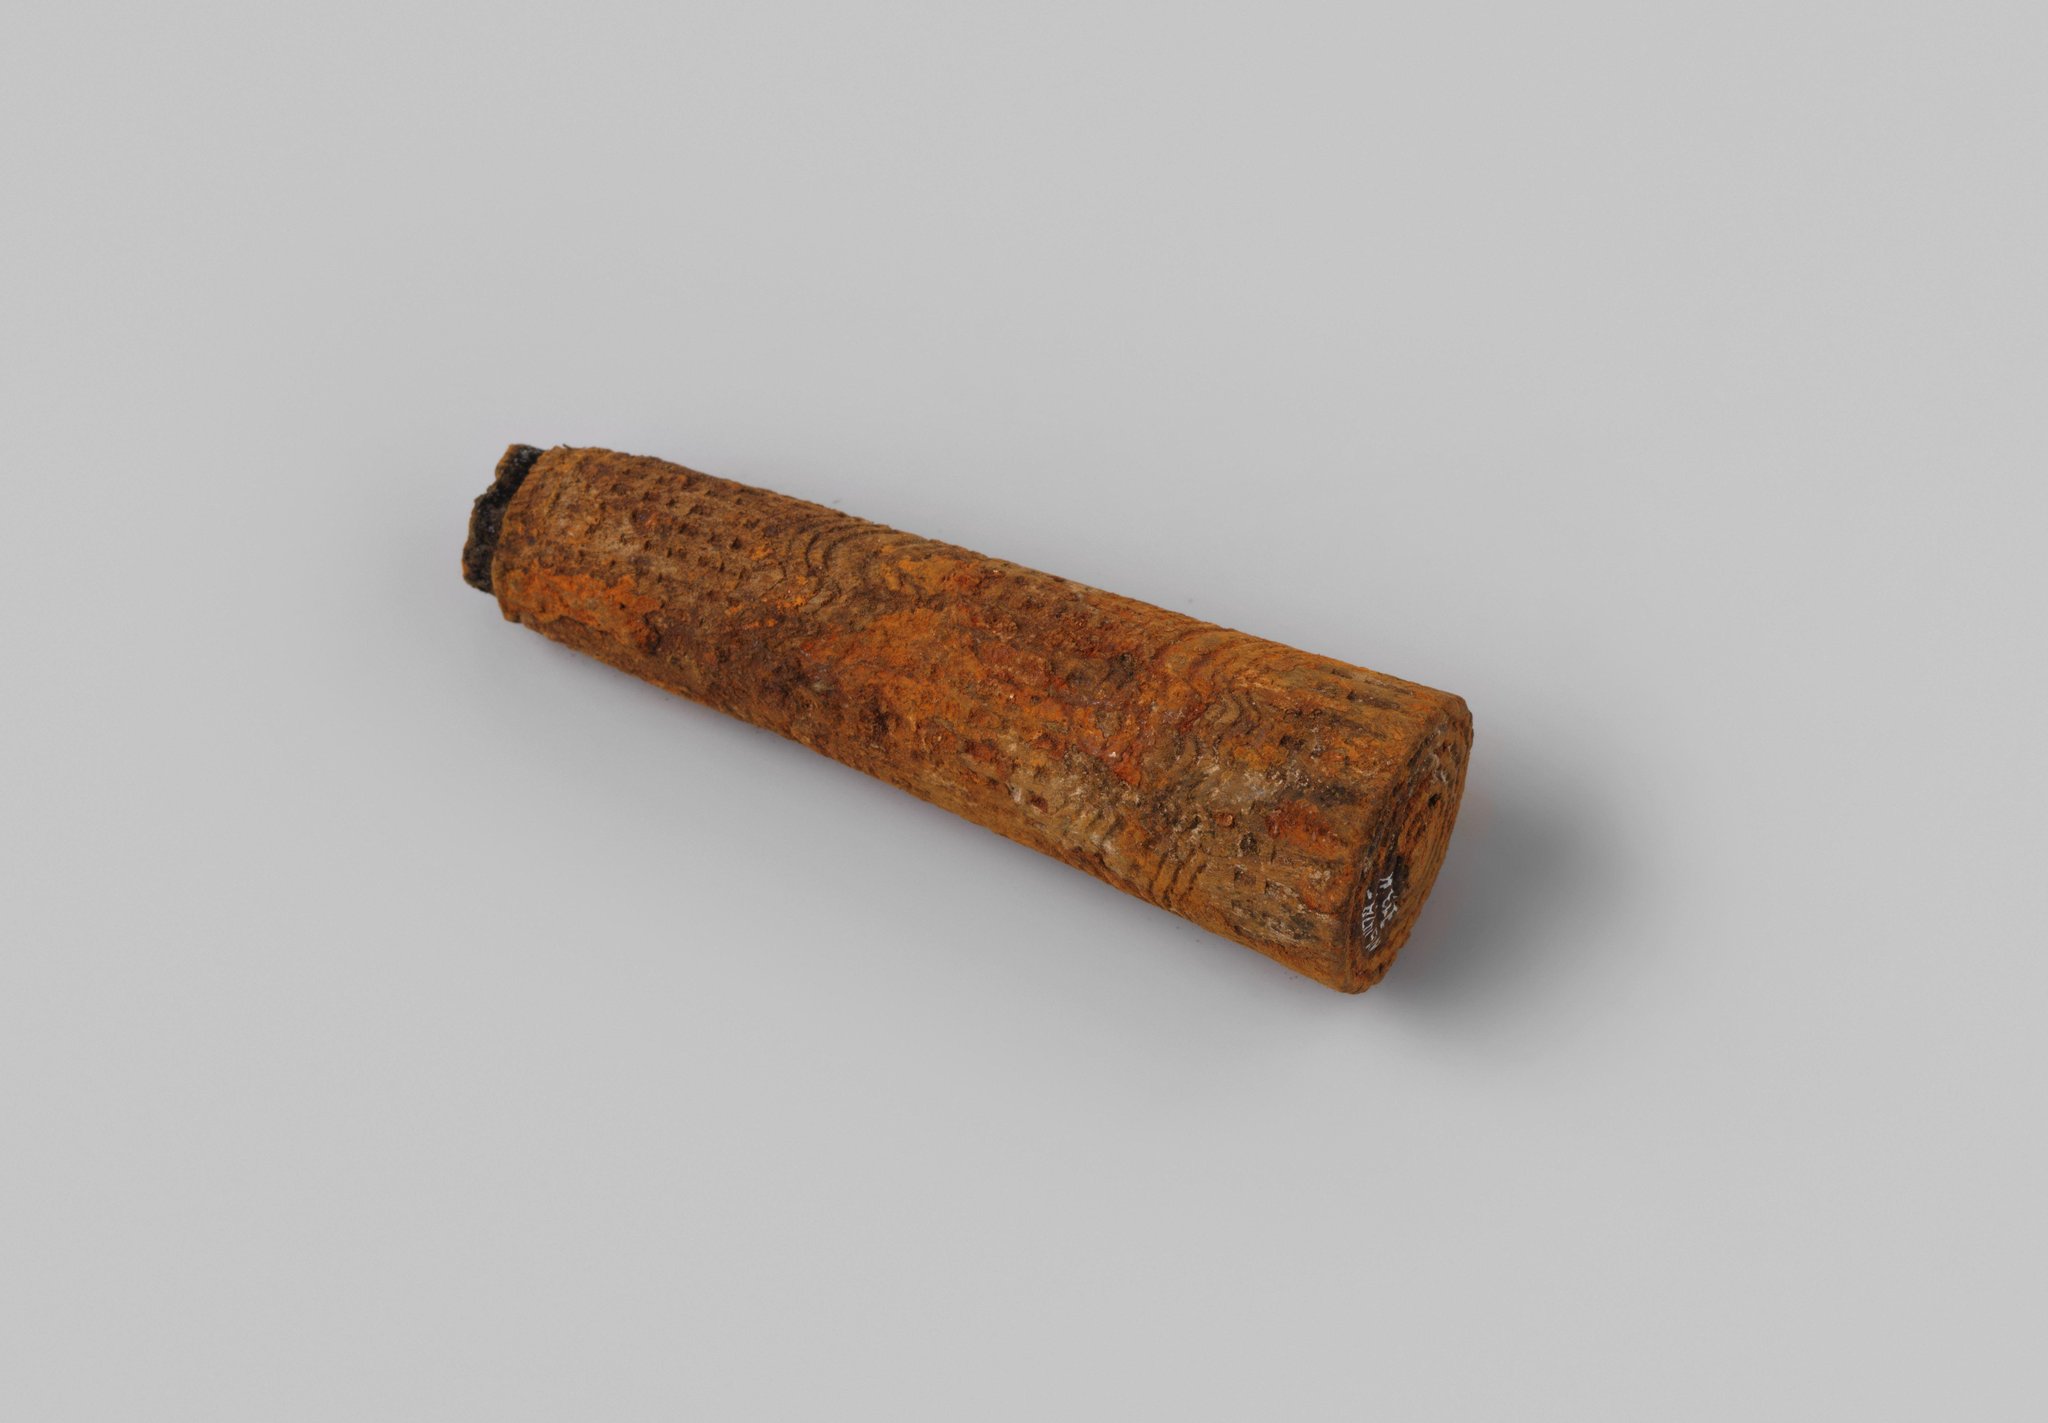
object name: knife handle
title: Messenheft uit het wrak van de Oost-Indiëvaarder Hollandia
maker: Anonymous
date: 1700-1743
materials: wood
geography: netherlands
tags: verenigde oostindische compagnie, hollandia (schip), annet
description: Knife, handle, cylindrical: tapering; id. NG 1979-403H, ferrules id. NG 1980-27H426.